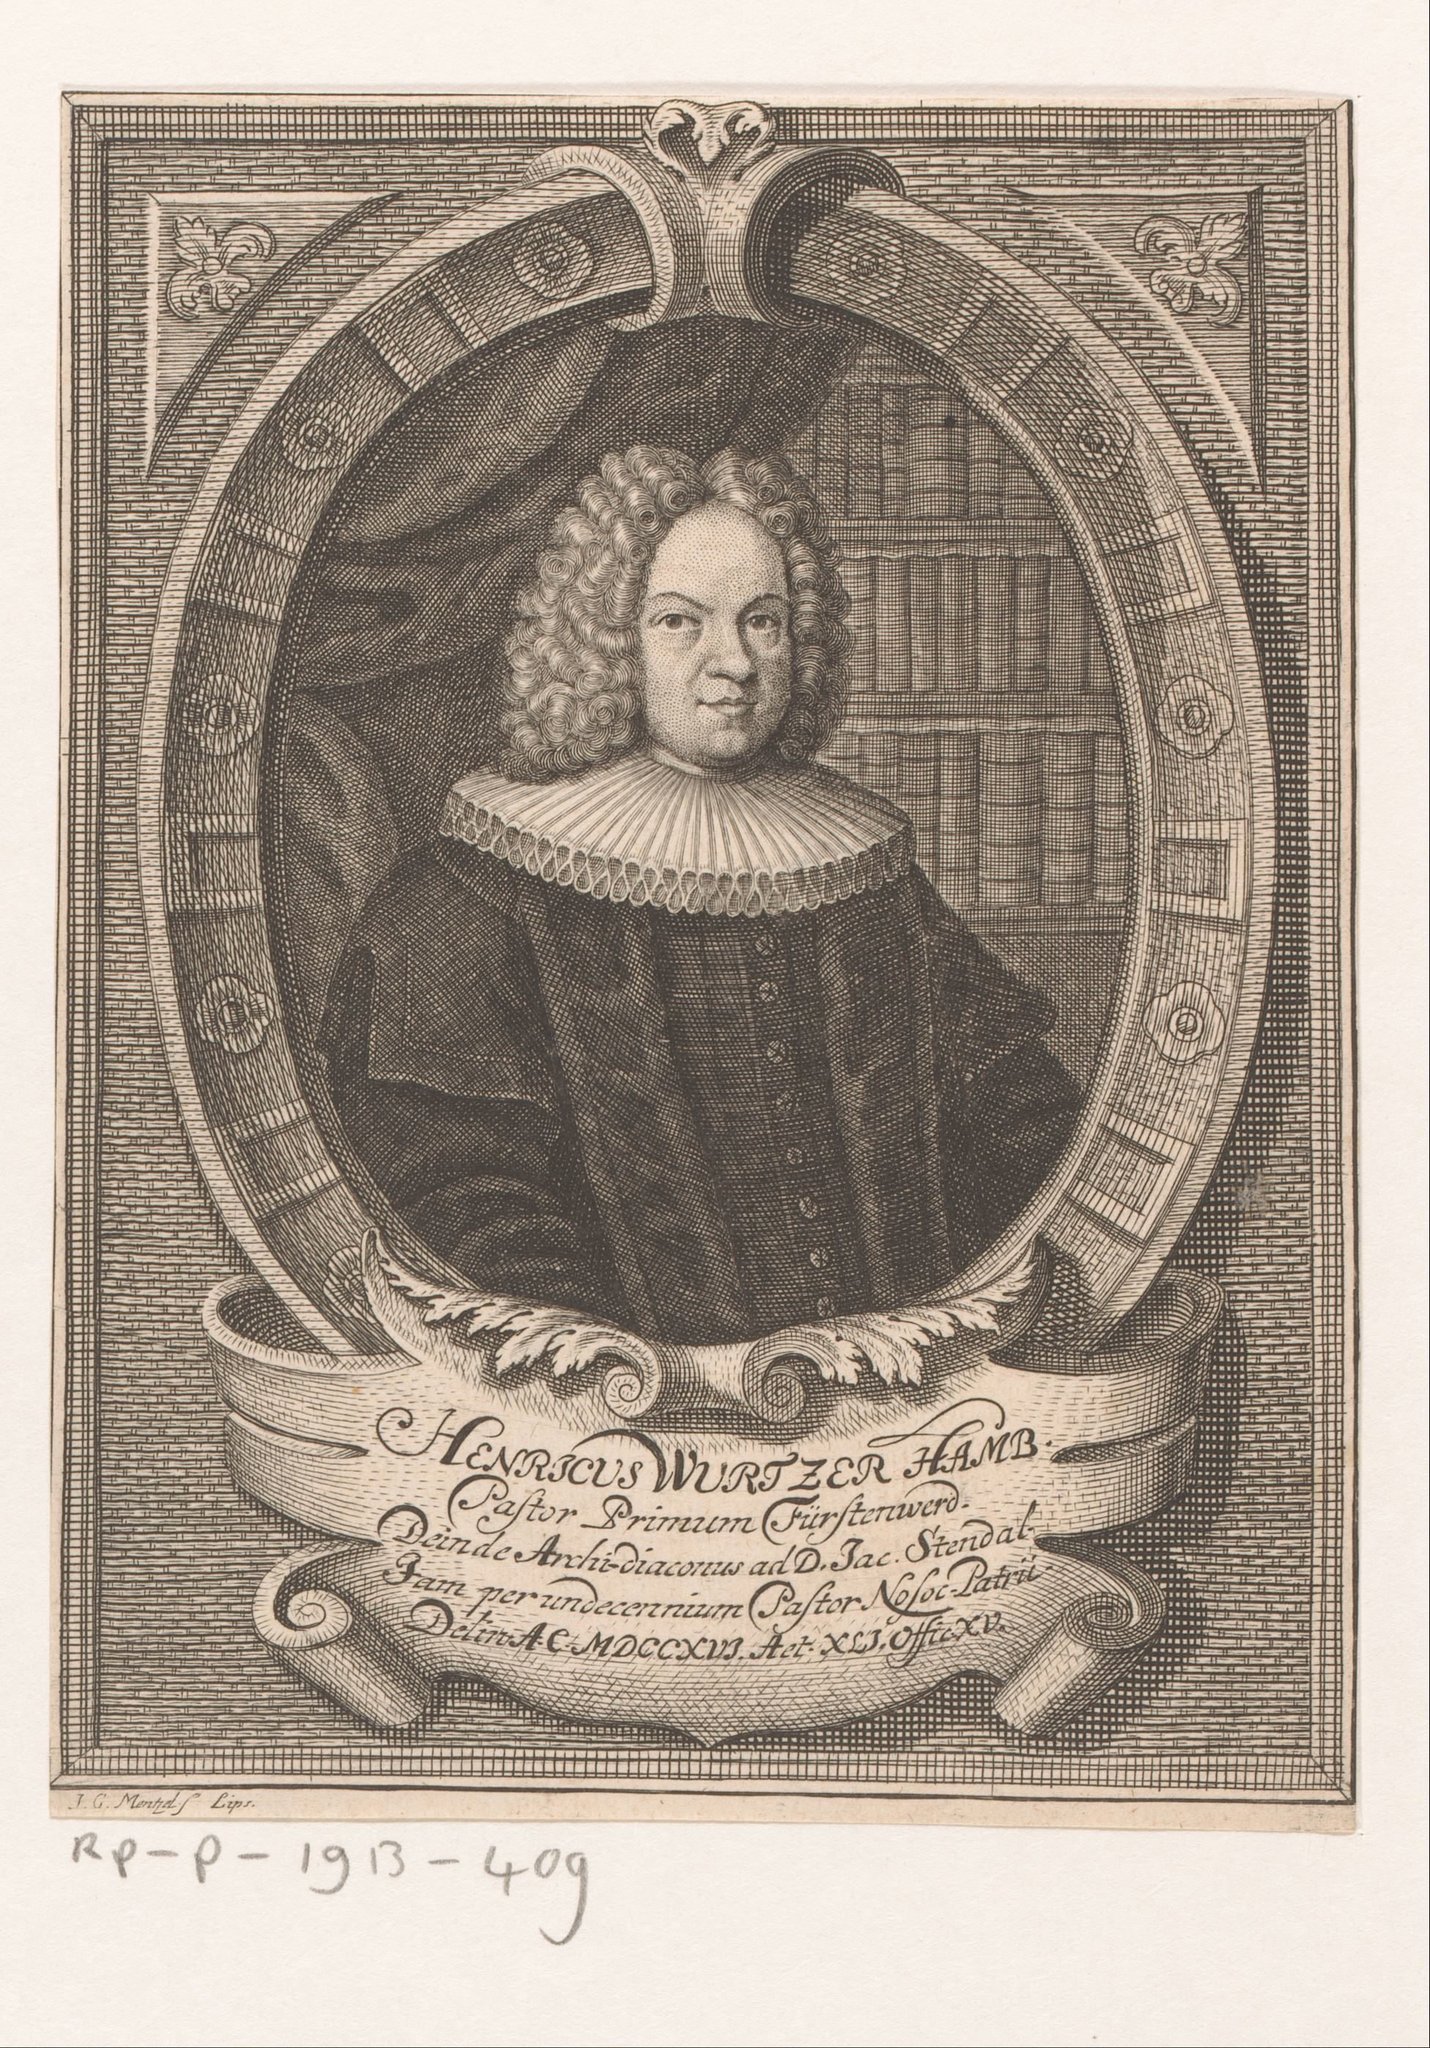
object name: print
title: Portret van Heinrich Wurtzer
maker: johann georg mentzel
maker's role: print maker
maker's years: 1677-1743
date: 1687-1743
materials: paper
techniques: engraving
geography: leipzig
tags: theologian, historical persons, wig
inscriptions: collector's mark: Lugt 2228